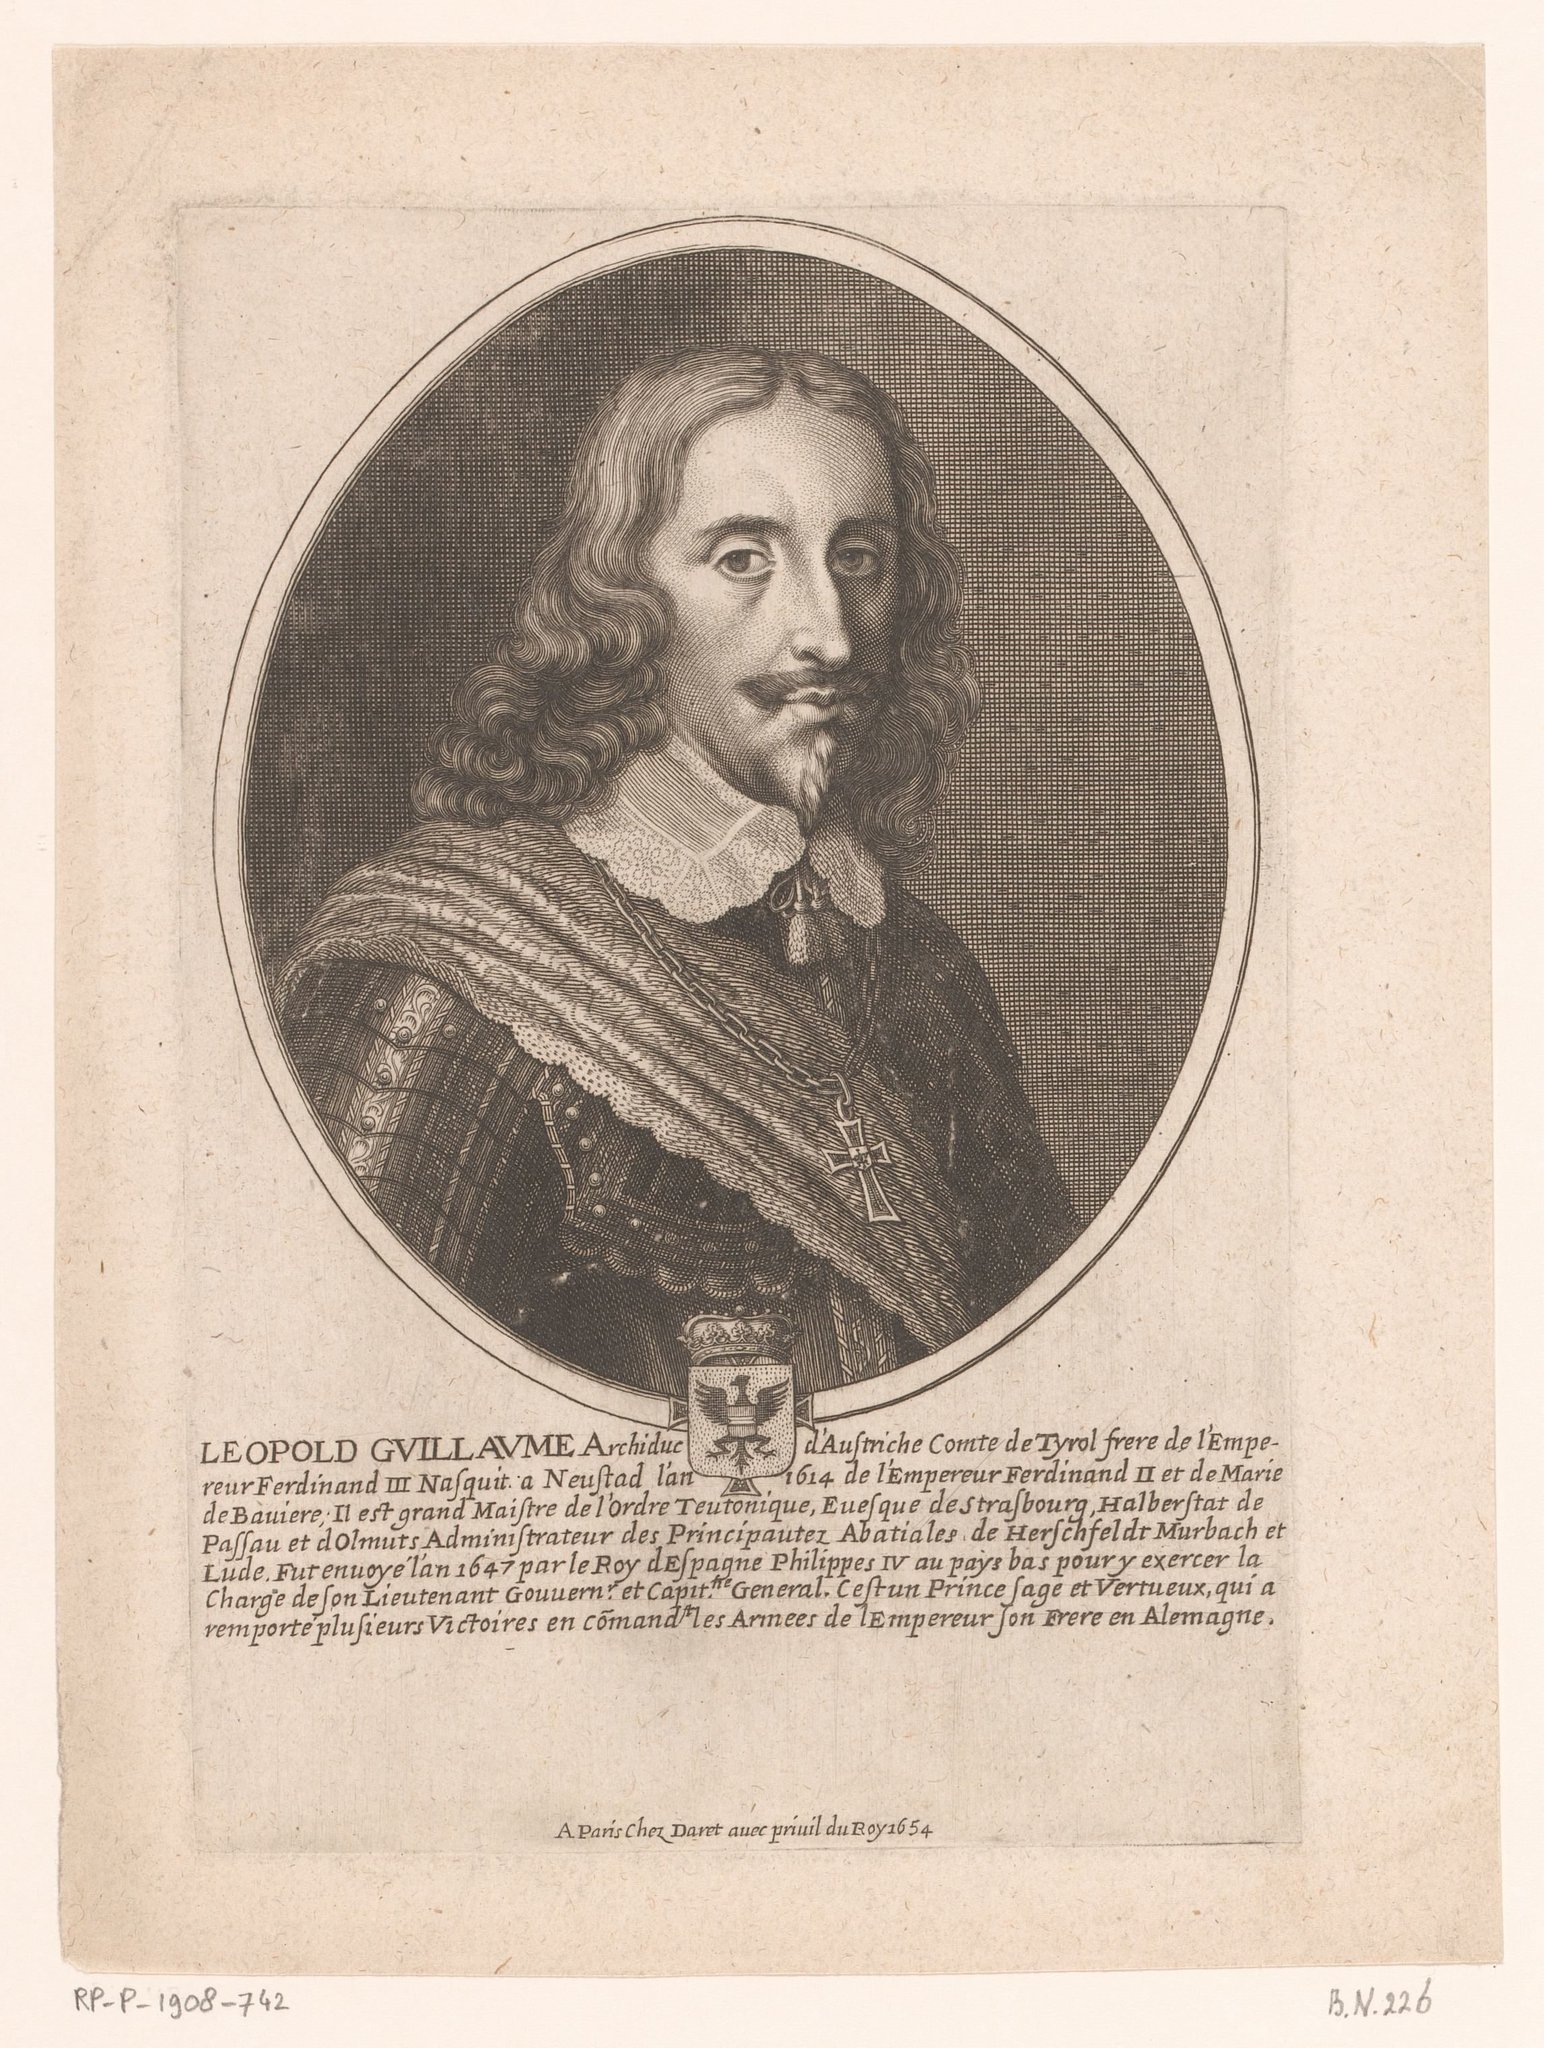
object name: print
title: Portret van Leopold Willem van Oostenrijk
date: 1654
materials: paper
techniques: engraving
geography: france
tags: vienna, leopold willem van oostenrijk (landvoogd der zuidelijke nederlanden), historical persons, armorial bearing, heraldry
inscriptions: collector's mark: Lugt 2228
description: Maakt deel uit van een serie portretten getiteld 'Tableaux historiques ou sont gravez les Illustres François et Etrangiers de l'un et l'autre sexe (...)', voor het eerst uitgegeven in 1652 door Daret. Een tweede staat werd uitgegeven door Boissevin en een derde door Jollain.